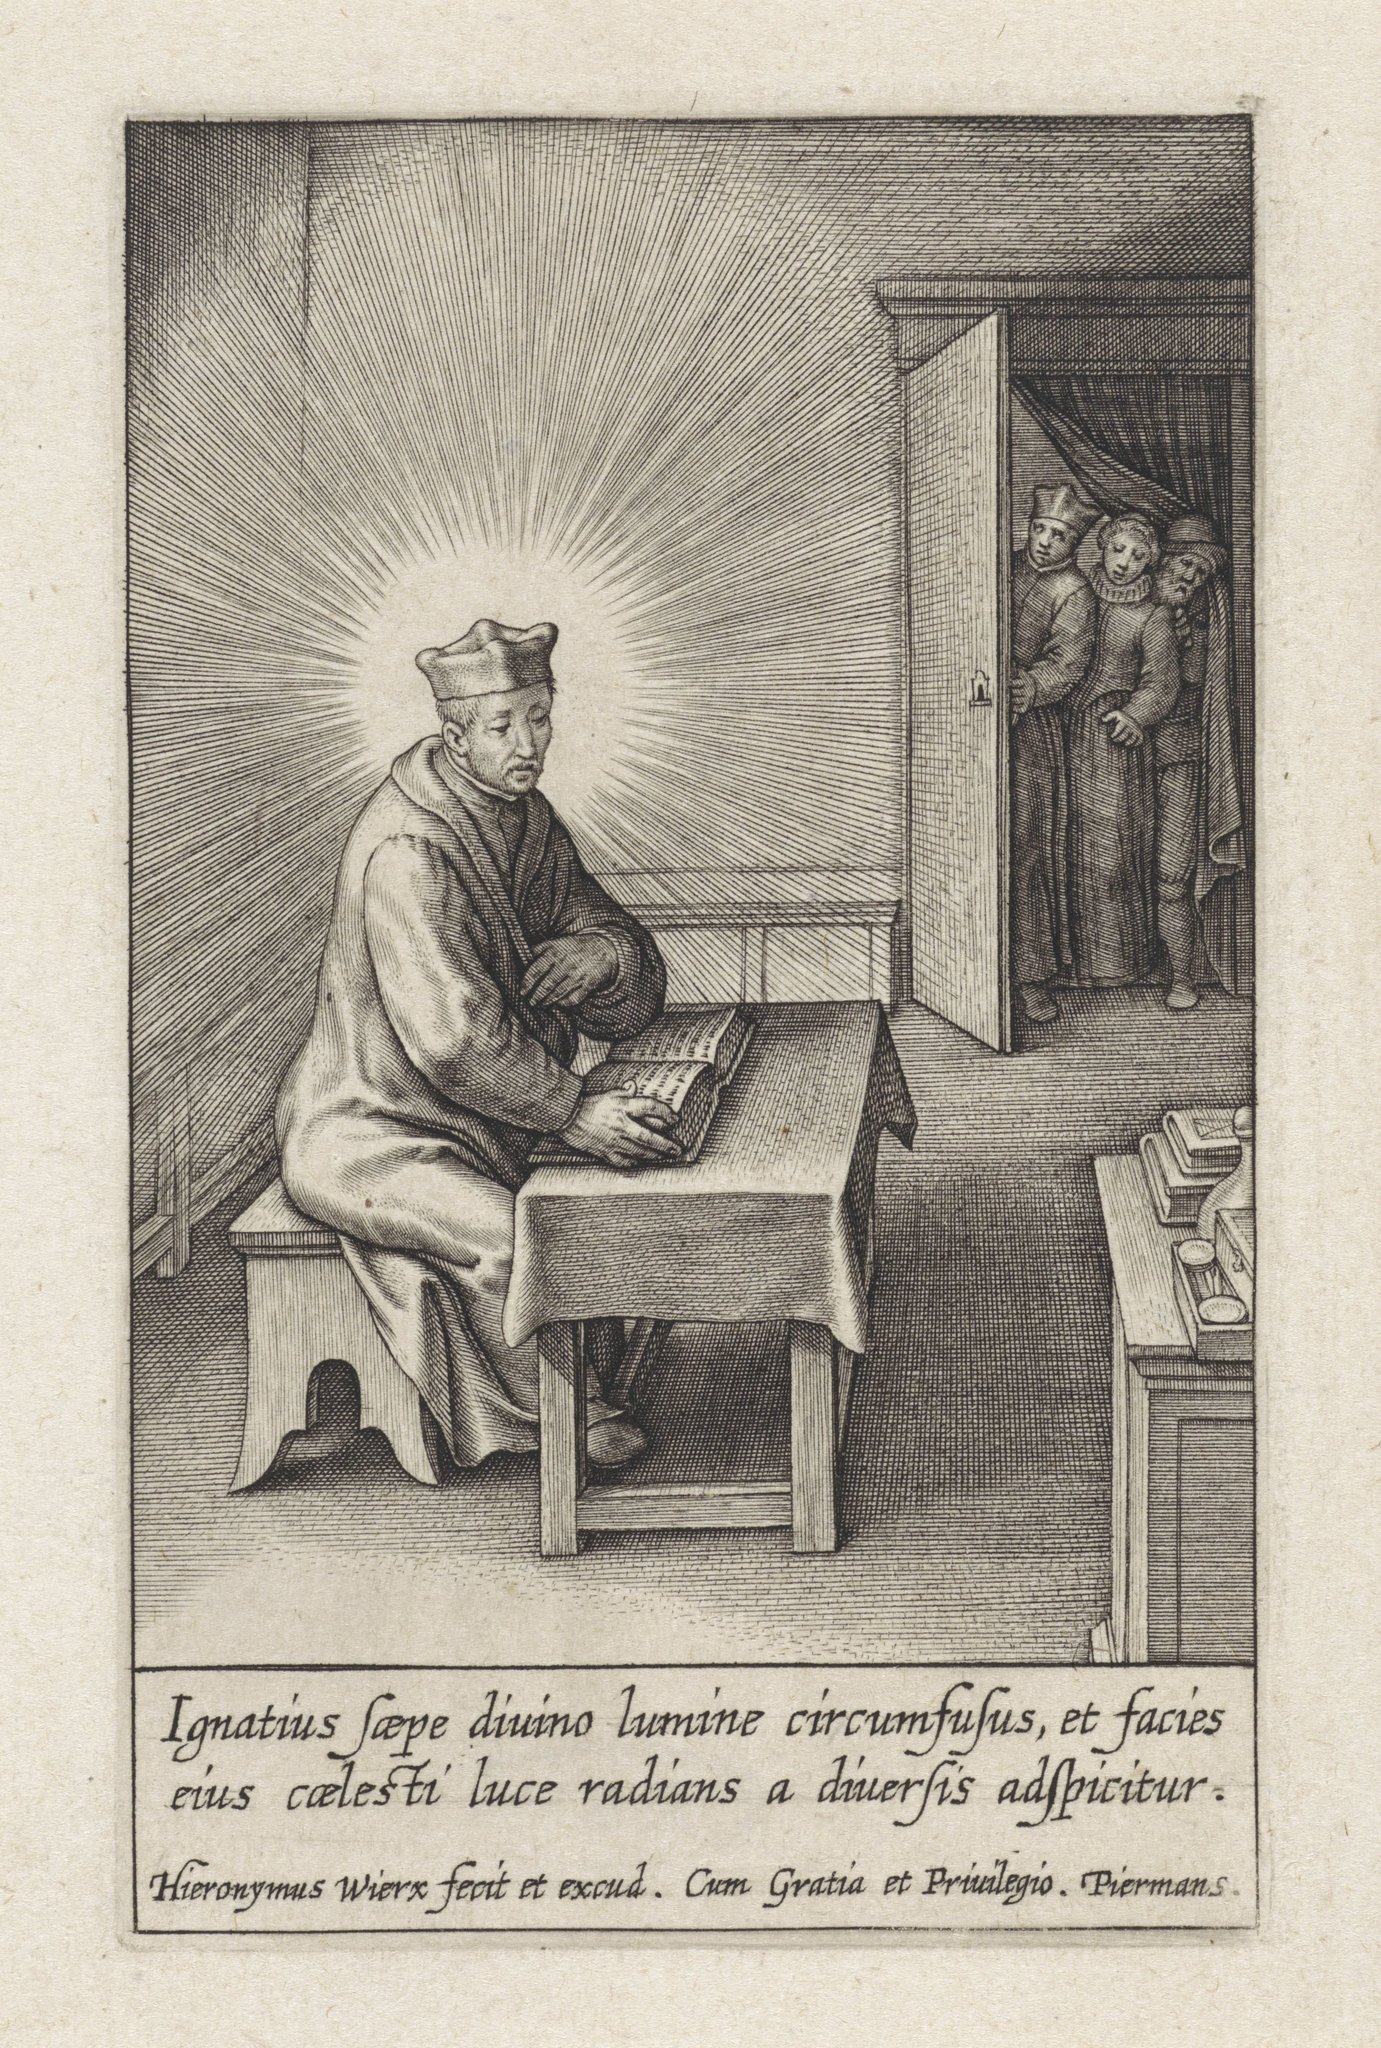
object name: print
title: Ignatius van Loyola omgeven door goddelijk licht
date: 1611-1615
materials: paper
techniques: engraving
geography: antwerp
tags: miraculous activities and events ~ st. ignatius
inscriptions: collector's mark: Lugt 2228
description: Ignatius van Loyola zit in zijn studeervertrek aan een tafel te lezen in een boek. Hij is omgeven door goddelijke stralen. Twee mannen en een vrouw kijken naar hem vanuit de deuropening. In de marge een tweeregelig onderschrift in het Latijn.